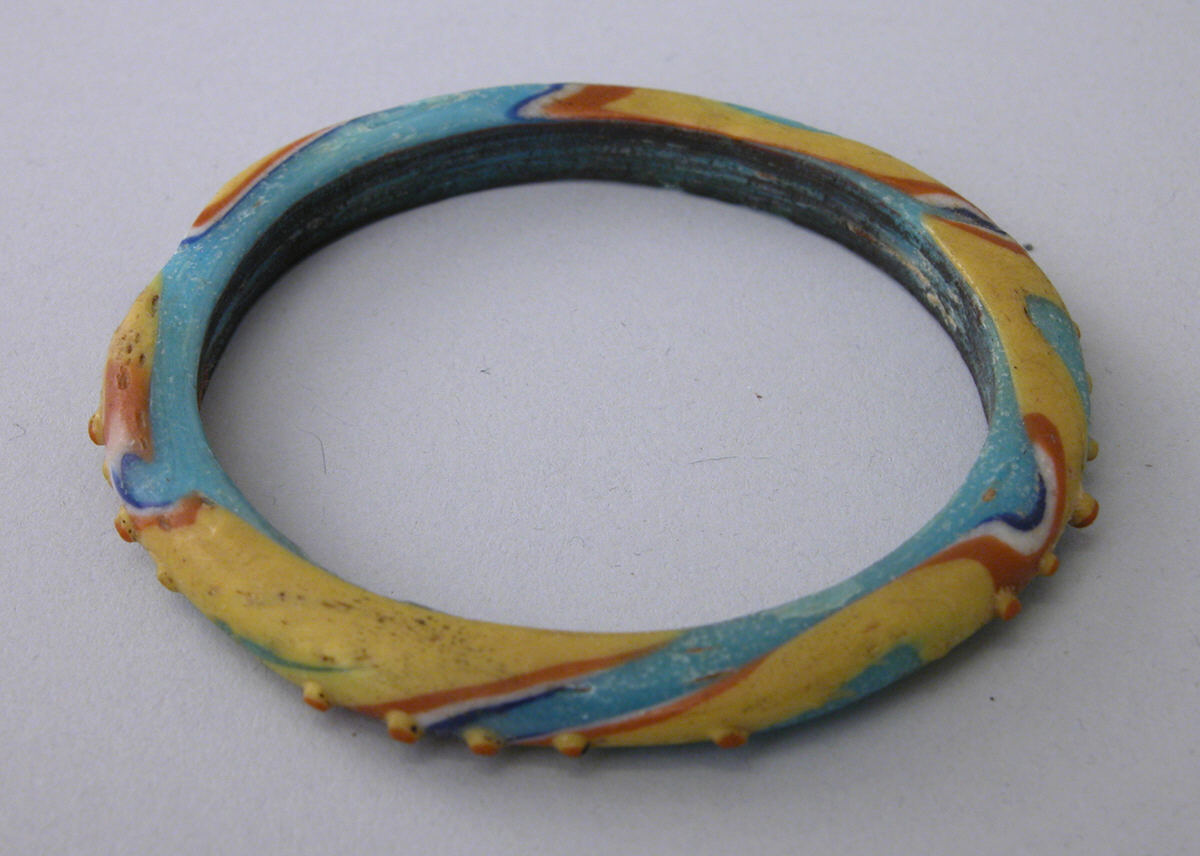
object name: bracelet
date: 1301-1500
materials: glass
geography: egypt or syria